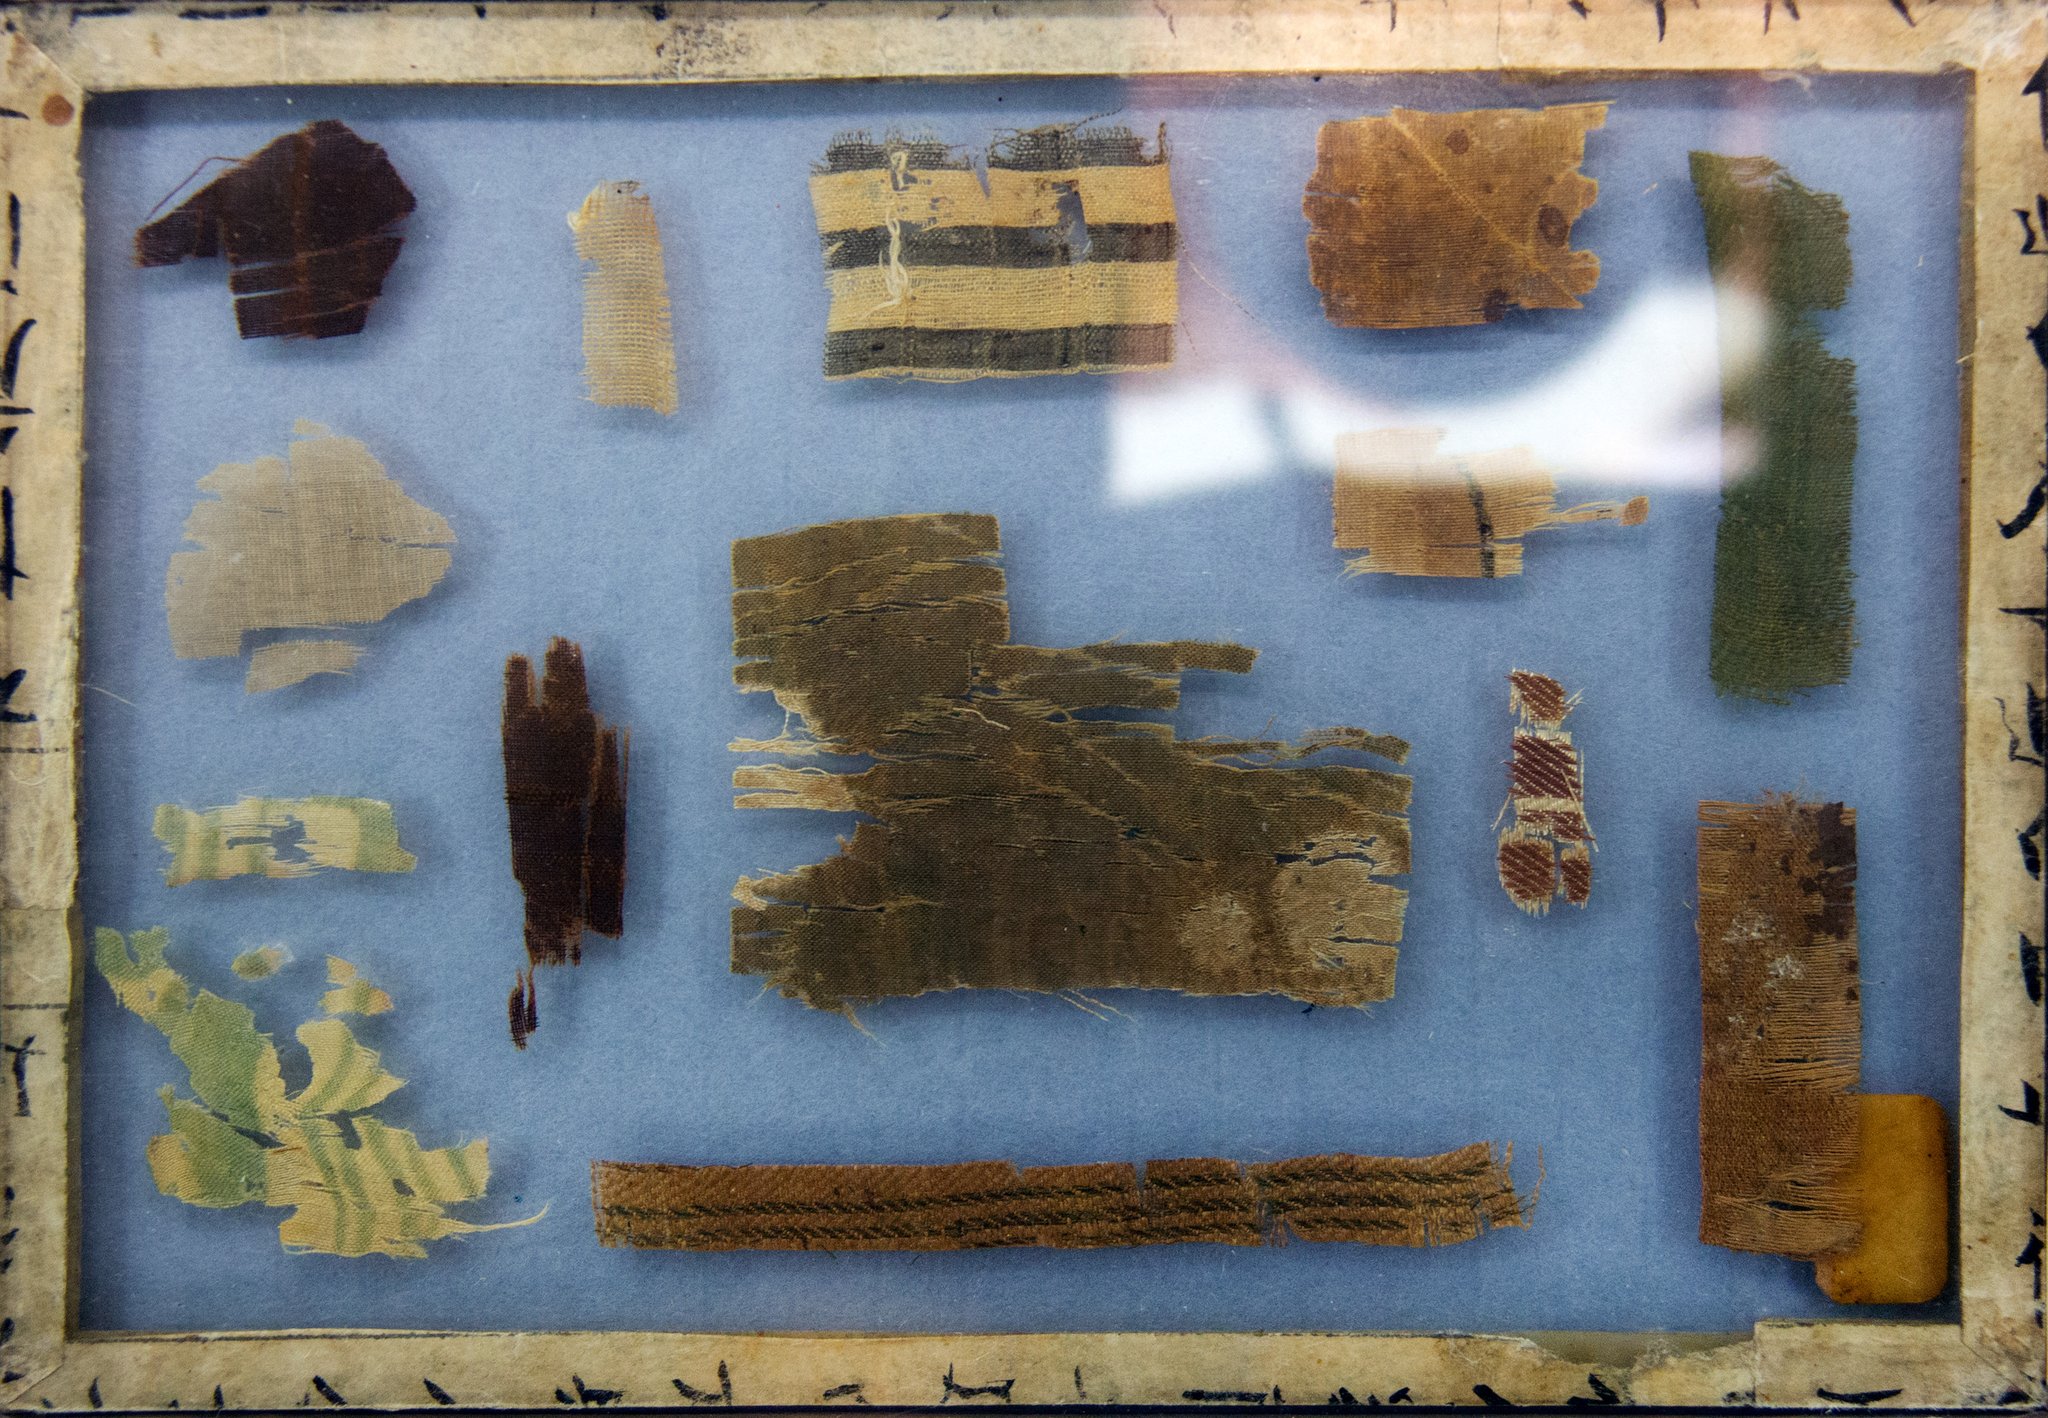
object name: fragment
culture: japanese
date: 701-800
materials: textile